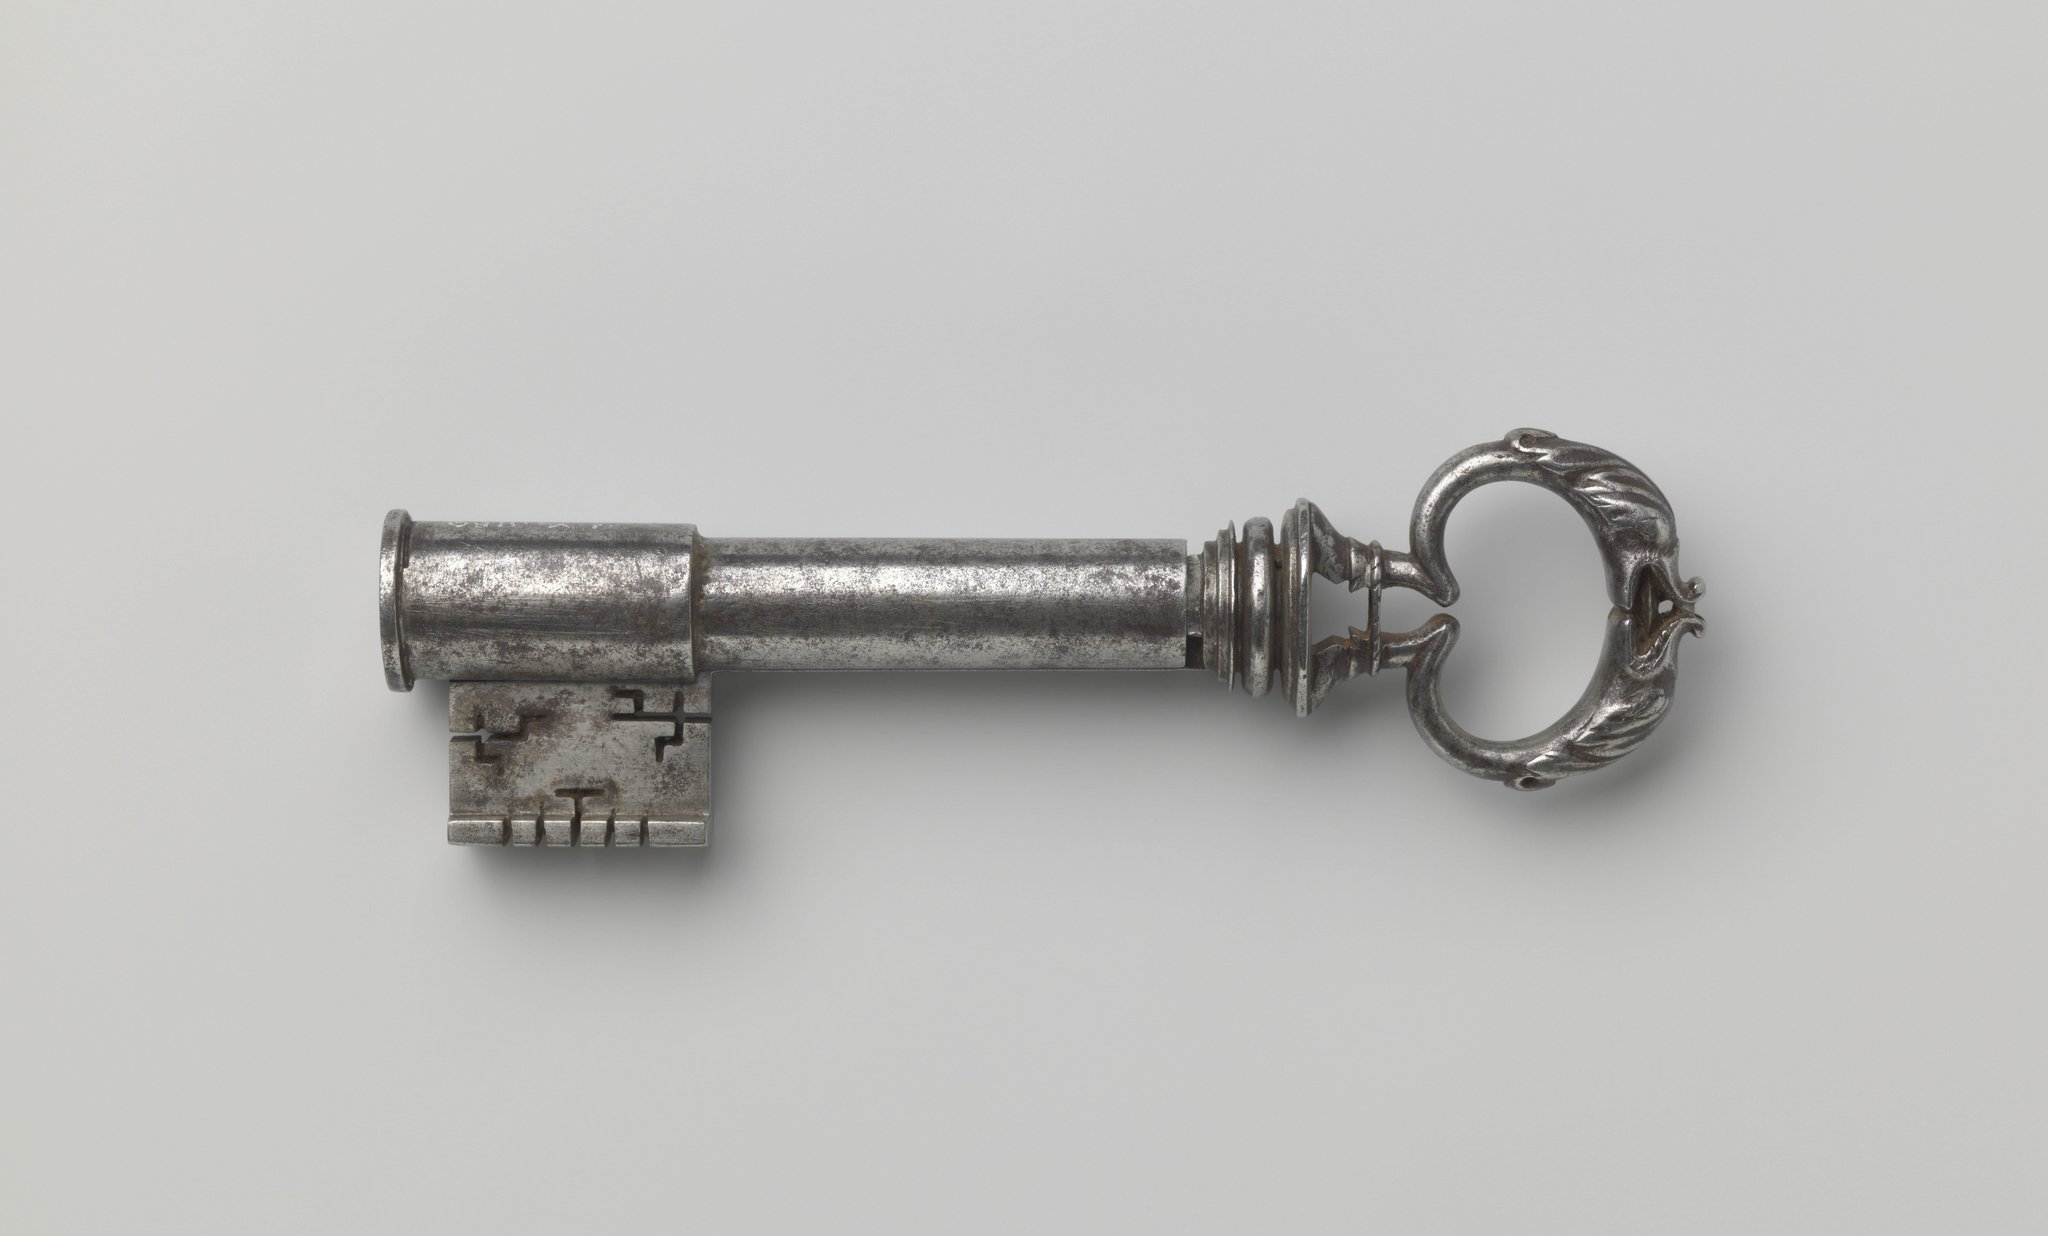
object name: key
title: Sleutel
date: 1600-1699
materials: iron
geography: france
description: Sleutel met twee dolfijnen, die de ring vormen.